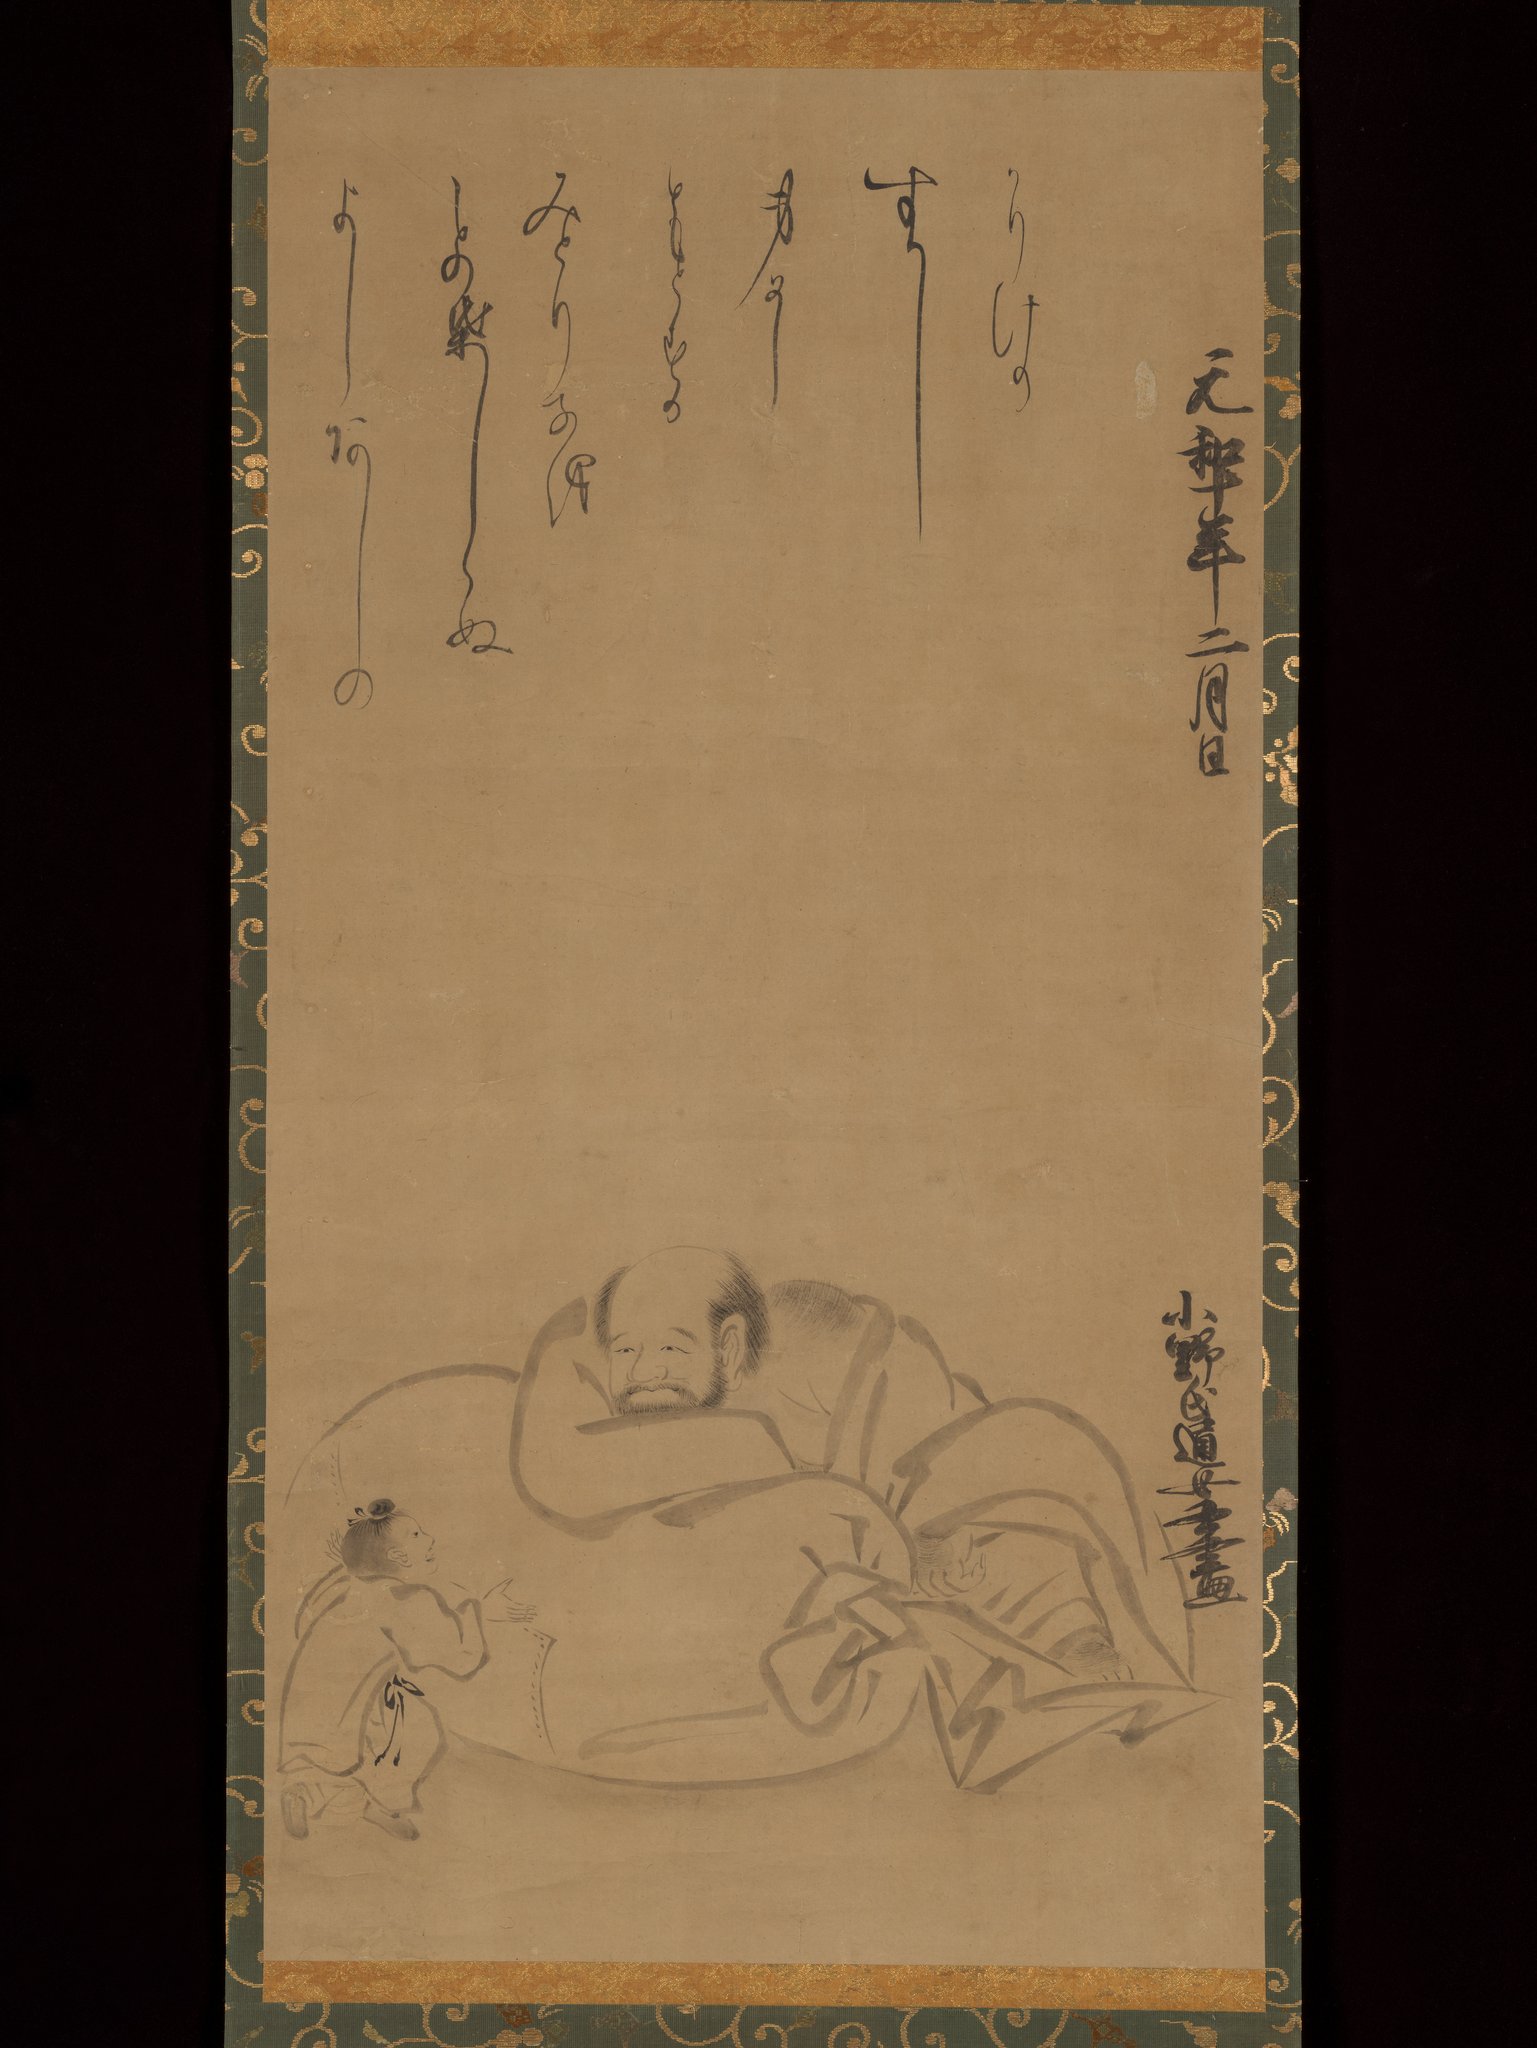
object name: hanging scroll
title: Hotei and a Child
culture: japanese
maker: ono no ozū (ono no tsū)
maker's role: artist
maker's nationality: japanese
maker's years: 1567-1631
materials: ink, paper